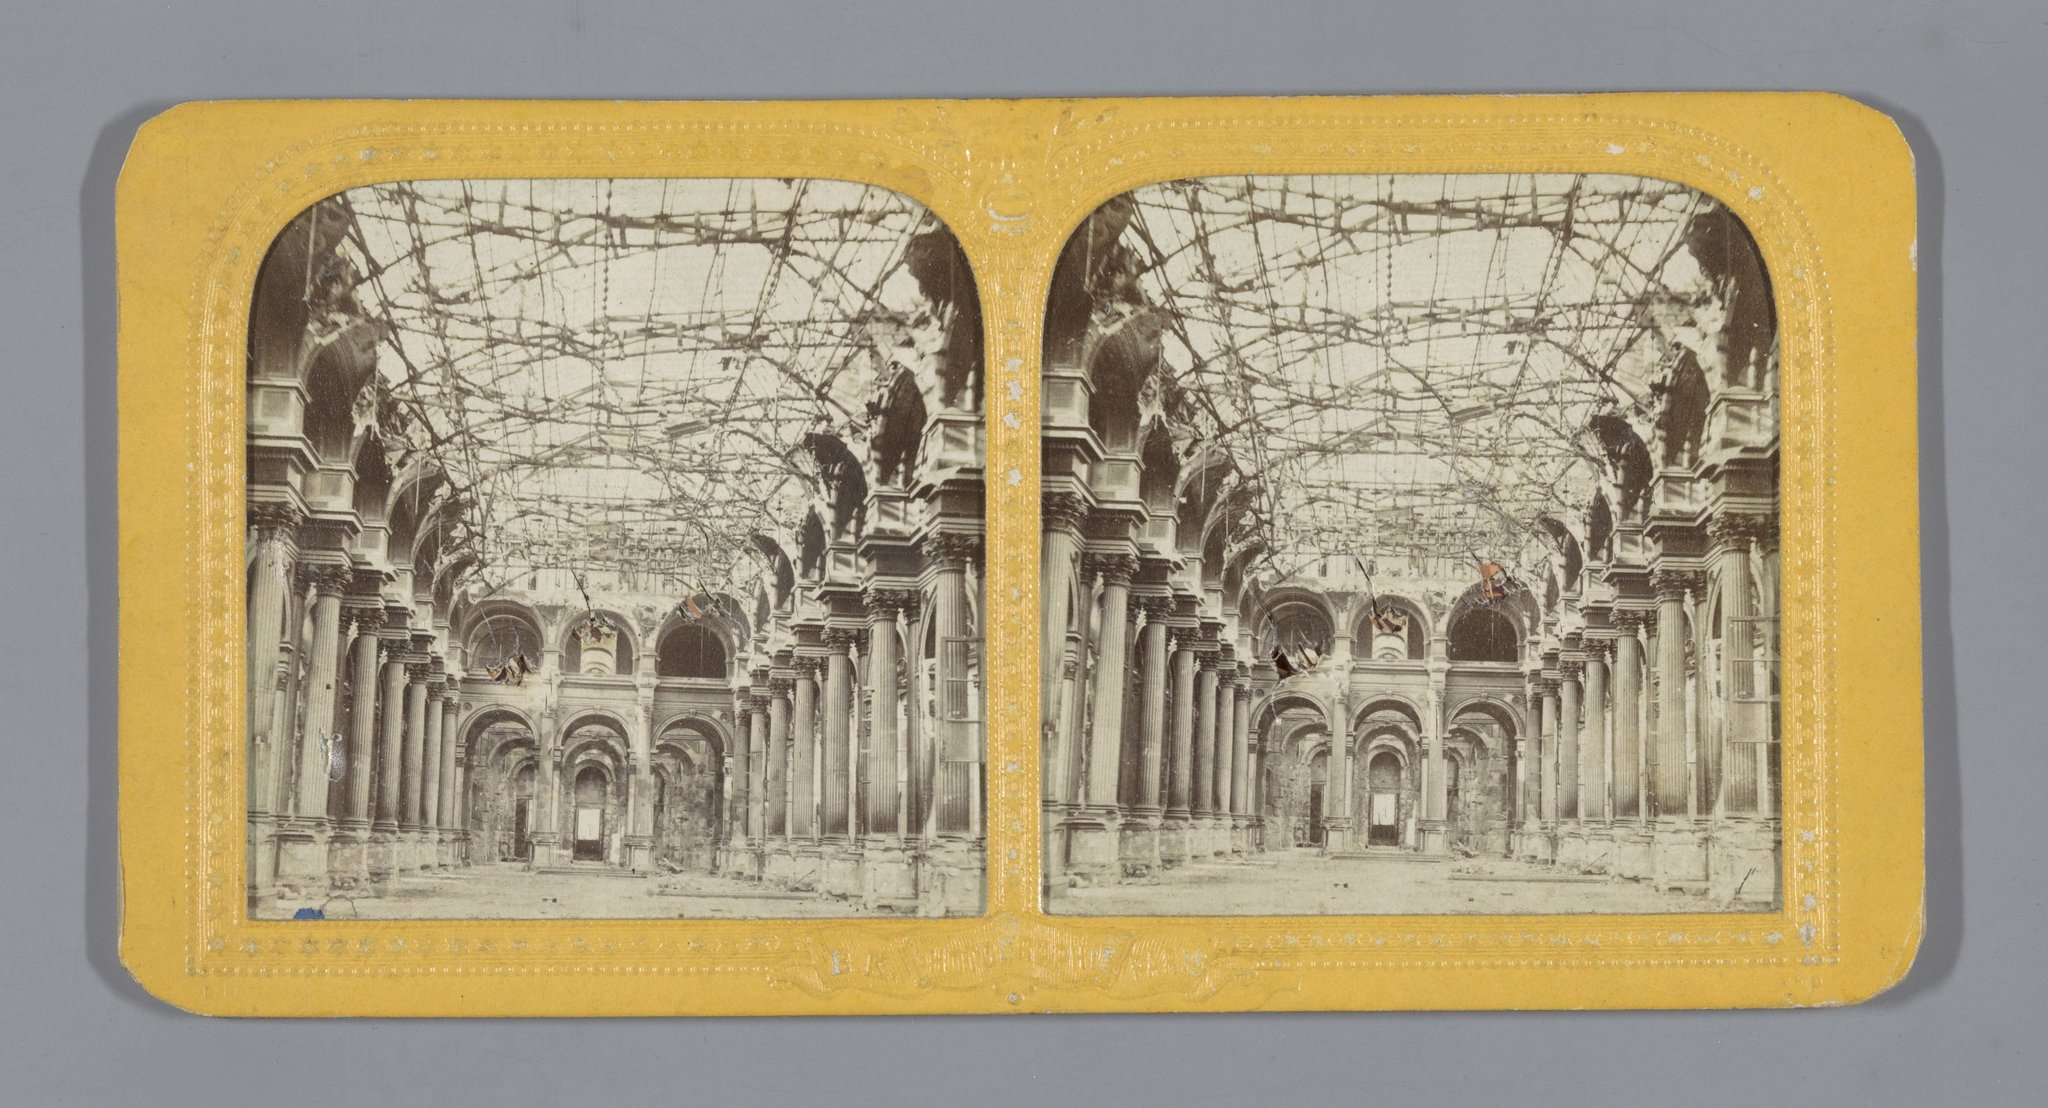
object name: tissue stereograph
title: Ruïne van de feestzaal in het stadhuis van tijdens de Commune van Parijs in 1871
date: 1871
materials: cardboard, paper, photographic support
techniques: albumen print, cutting, hand coloring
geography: paris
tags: townhall, devastated, ruined place or city (~ warfare), burning as process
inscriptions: check stamp: ‘B.K. PHOTOGRAPHIE PARIS’, inscription: ‘Ch D’, inscription: ‘Déposé’